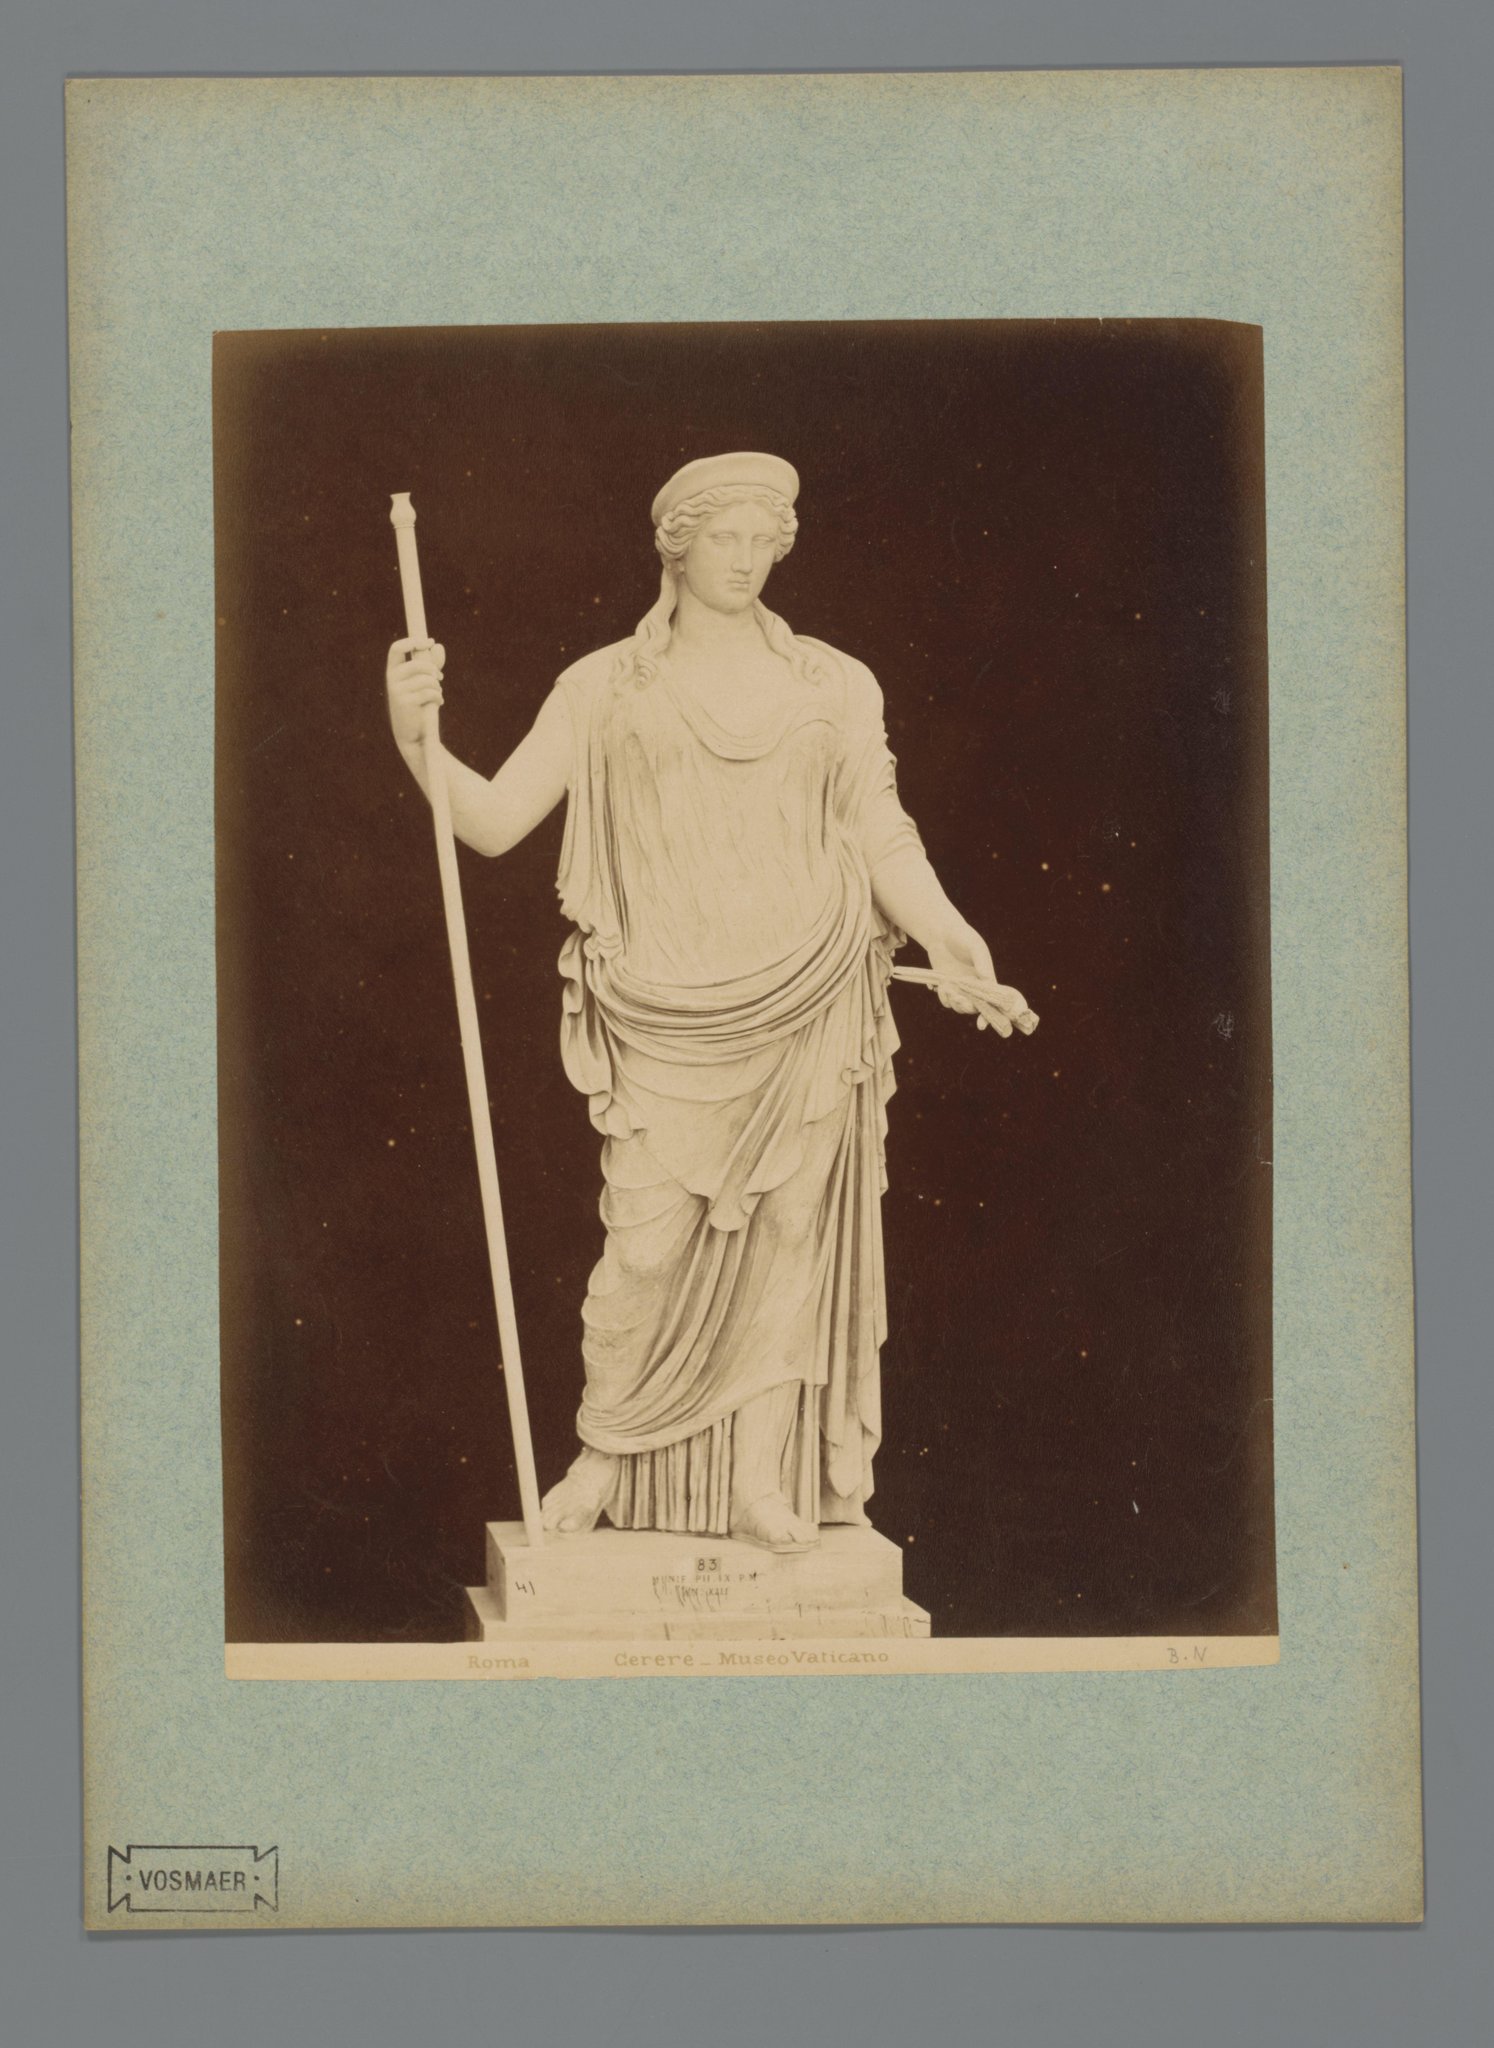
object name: photograph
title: Standbeeld van Ceres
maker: Anonymous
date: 1851-1900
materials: cardboard, paper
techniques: albumen print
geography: vatican city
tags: monument, statue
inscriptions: collector's mark: ‘VOSMAER’, number: ‘41’, inscription: ‘B.N’